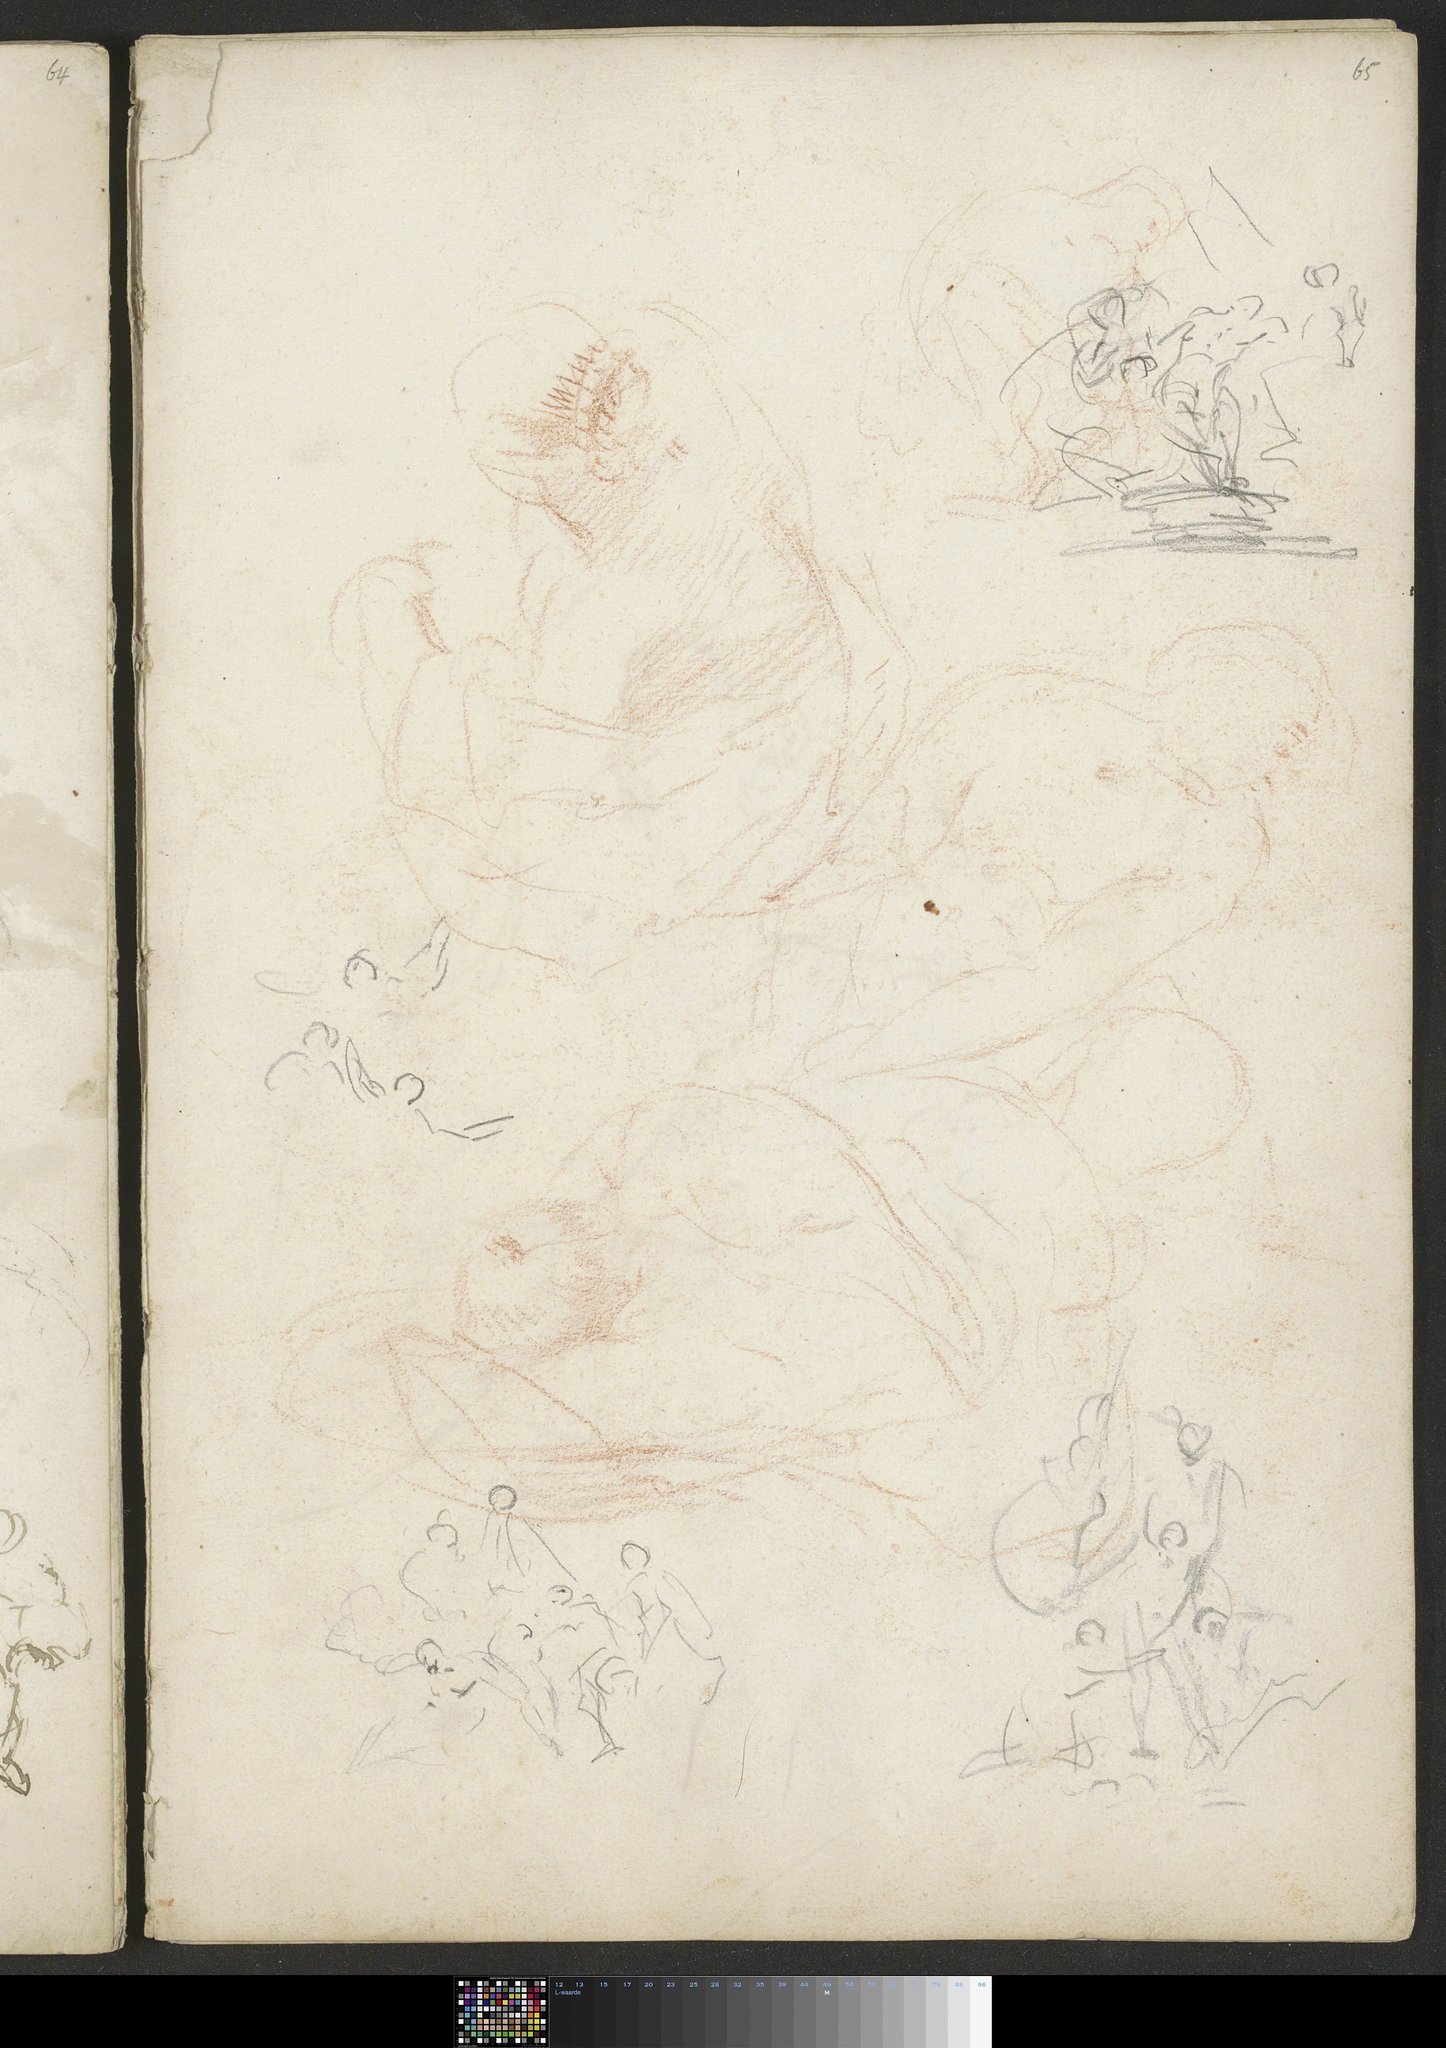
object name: sketchbook leaf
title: Figuurstudies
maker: Anonymous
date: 1650-1799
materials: chalk, paper, pencil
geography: italy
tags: anatomy (non-medical)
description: Bladzijde 65 uit een schetsboek met 72 bladzijden.